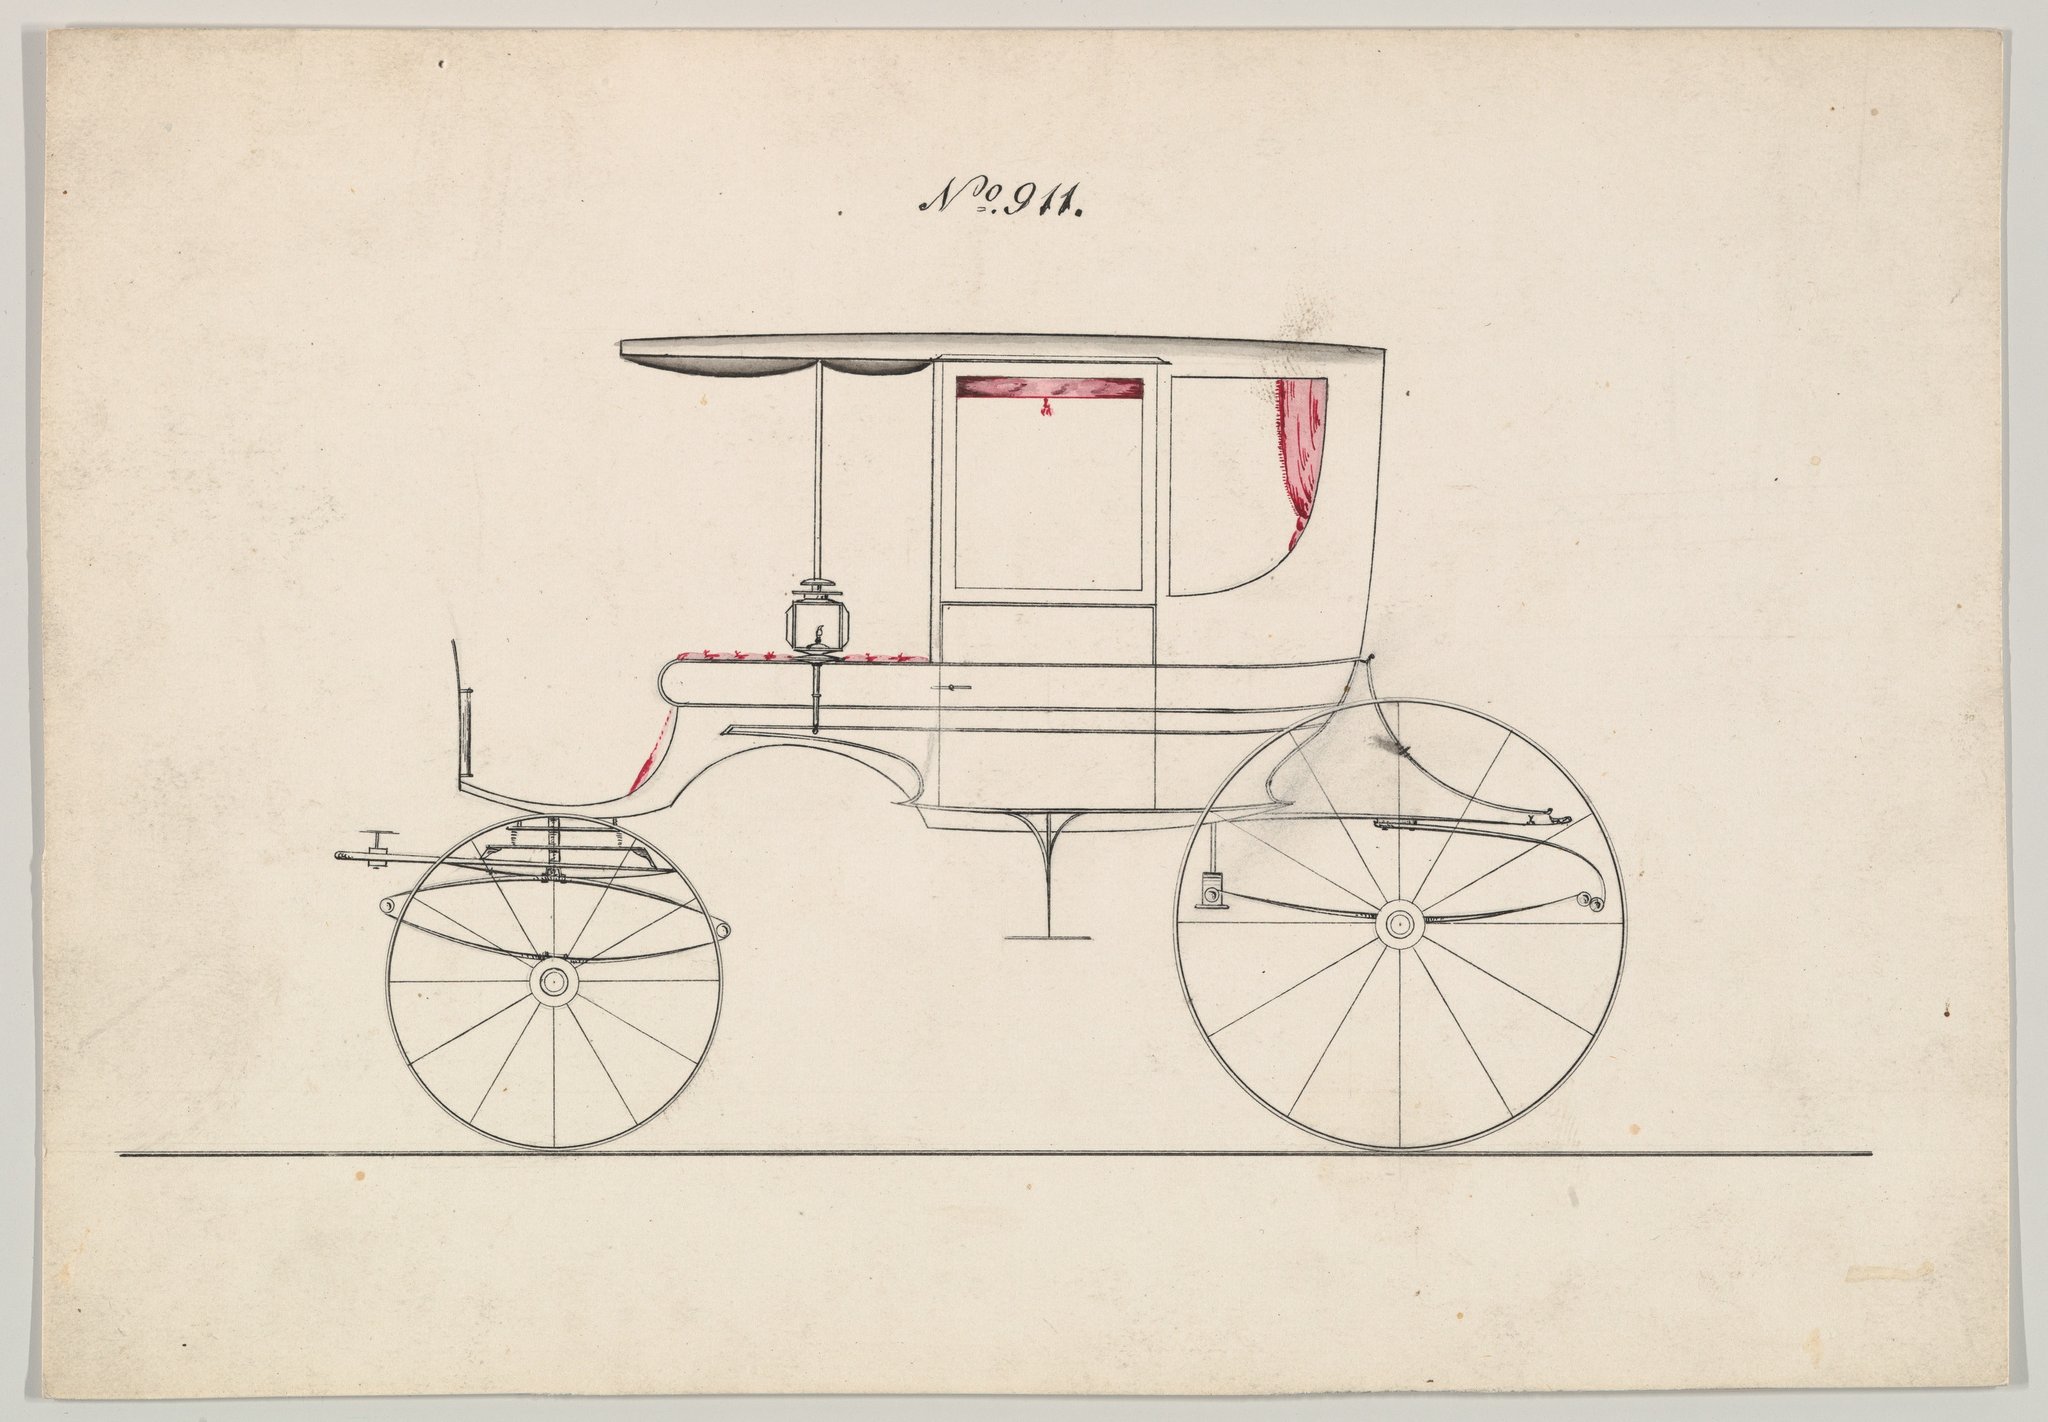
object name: drawing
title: Rockaway #911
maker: brewster & co.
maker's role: manufacturer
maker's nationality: american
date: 1865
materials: gouache, ink, watercolor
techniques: pen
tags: carriages